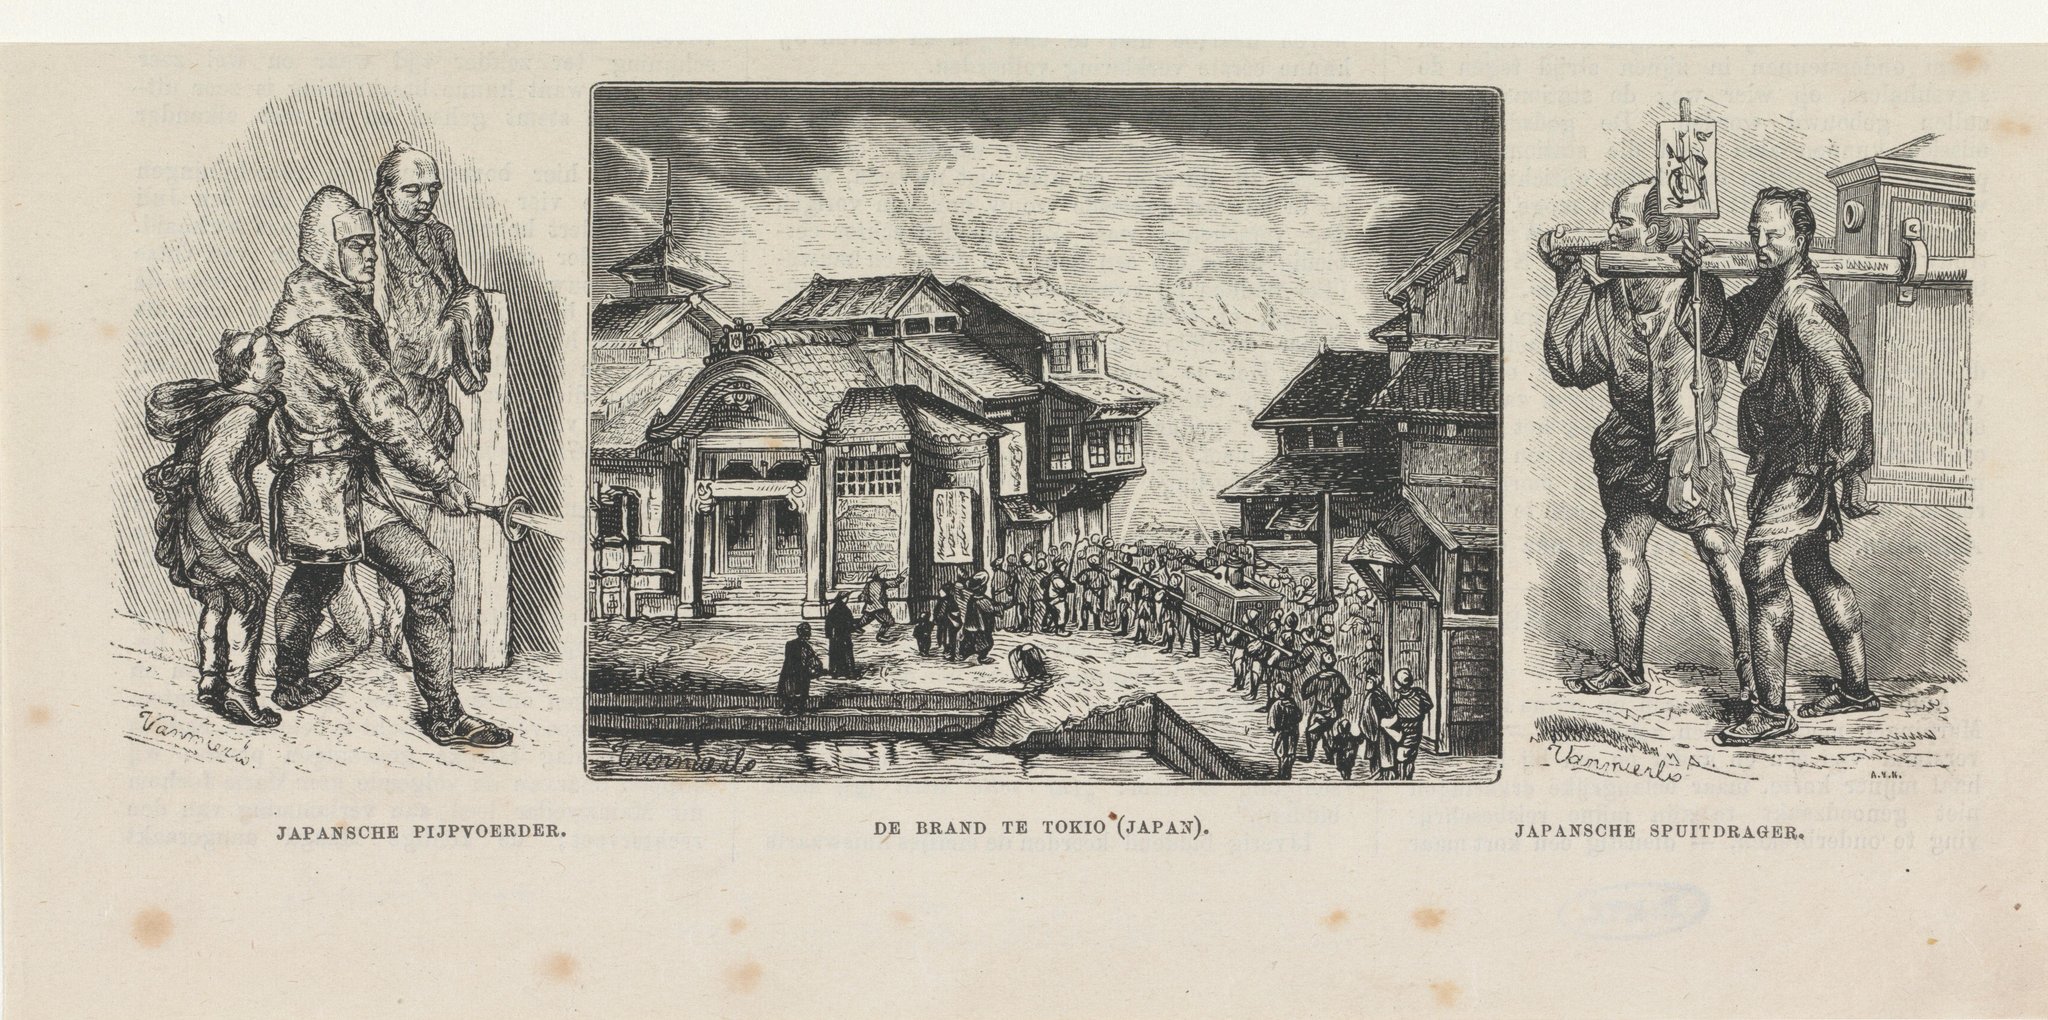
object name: book illustration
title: Japansche spuitdrager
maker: van mierlo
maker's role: print maker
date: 1876-1877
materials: paper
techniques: letterpress printing, engraving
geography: netherlands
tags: fire-fighting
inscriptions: collector's mark: Lugt 2760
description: Prent uit: De Katholieke illustratie. 1876-1877.